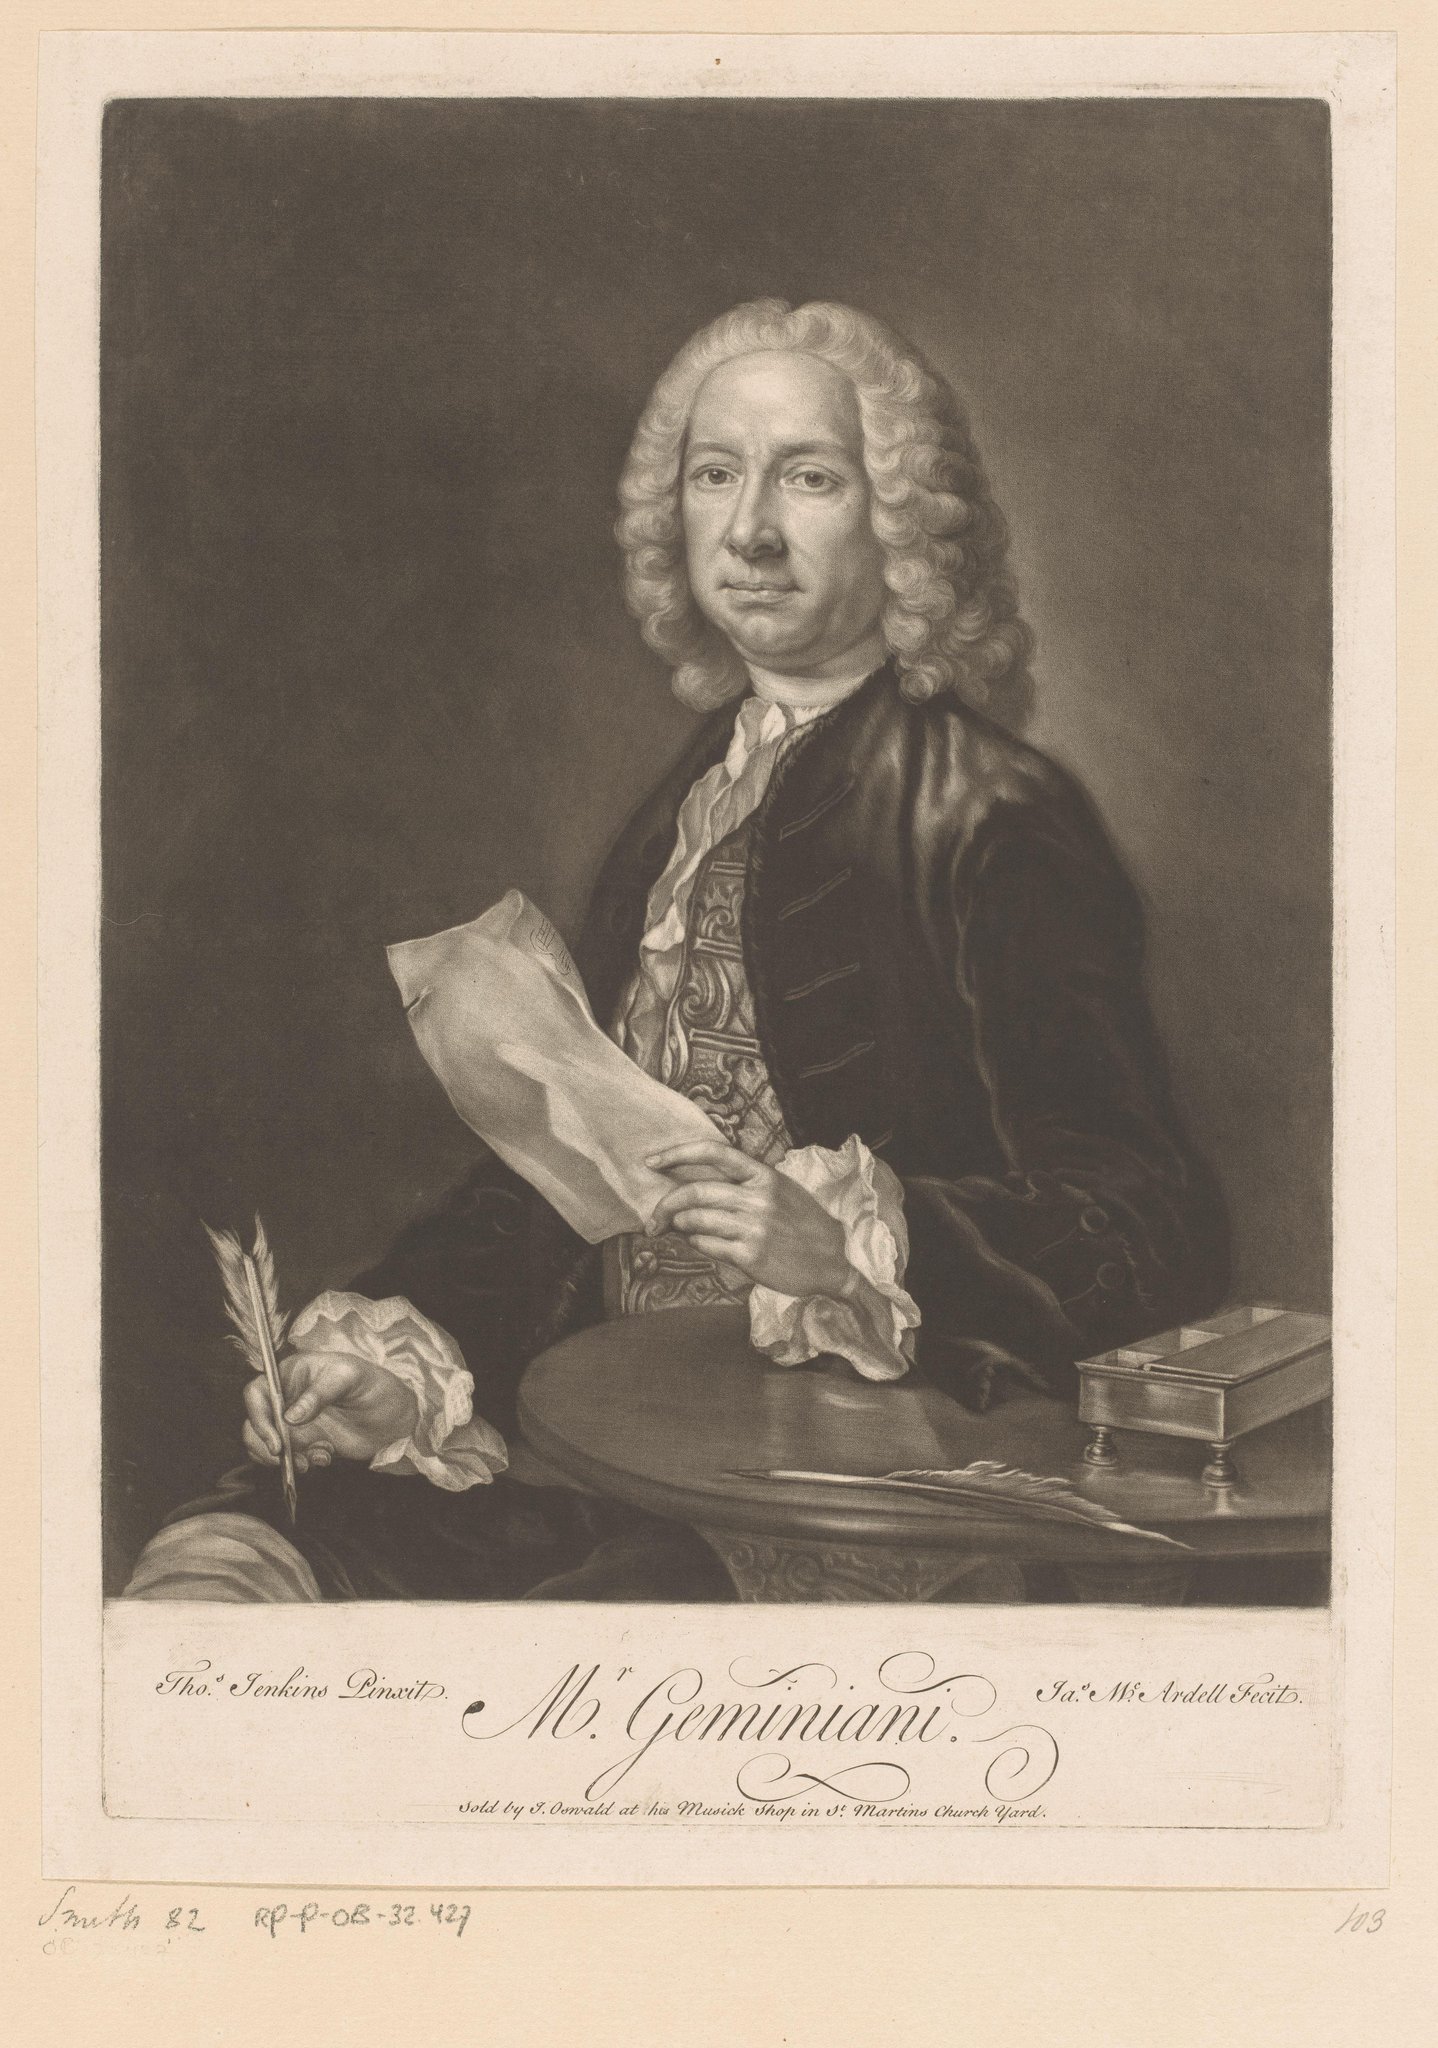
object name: print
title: Portret van Francesco Geminiani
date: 1741-1762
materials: paper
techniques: mezzotint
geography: london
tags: historical persons, portrait of composer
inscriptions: collector's mark: Lugt 240